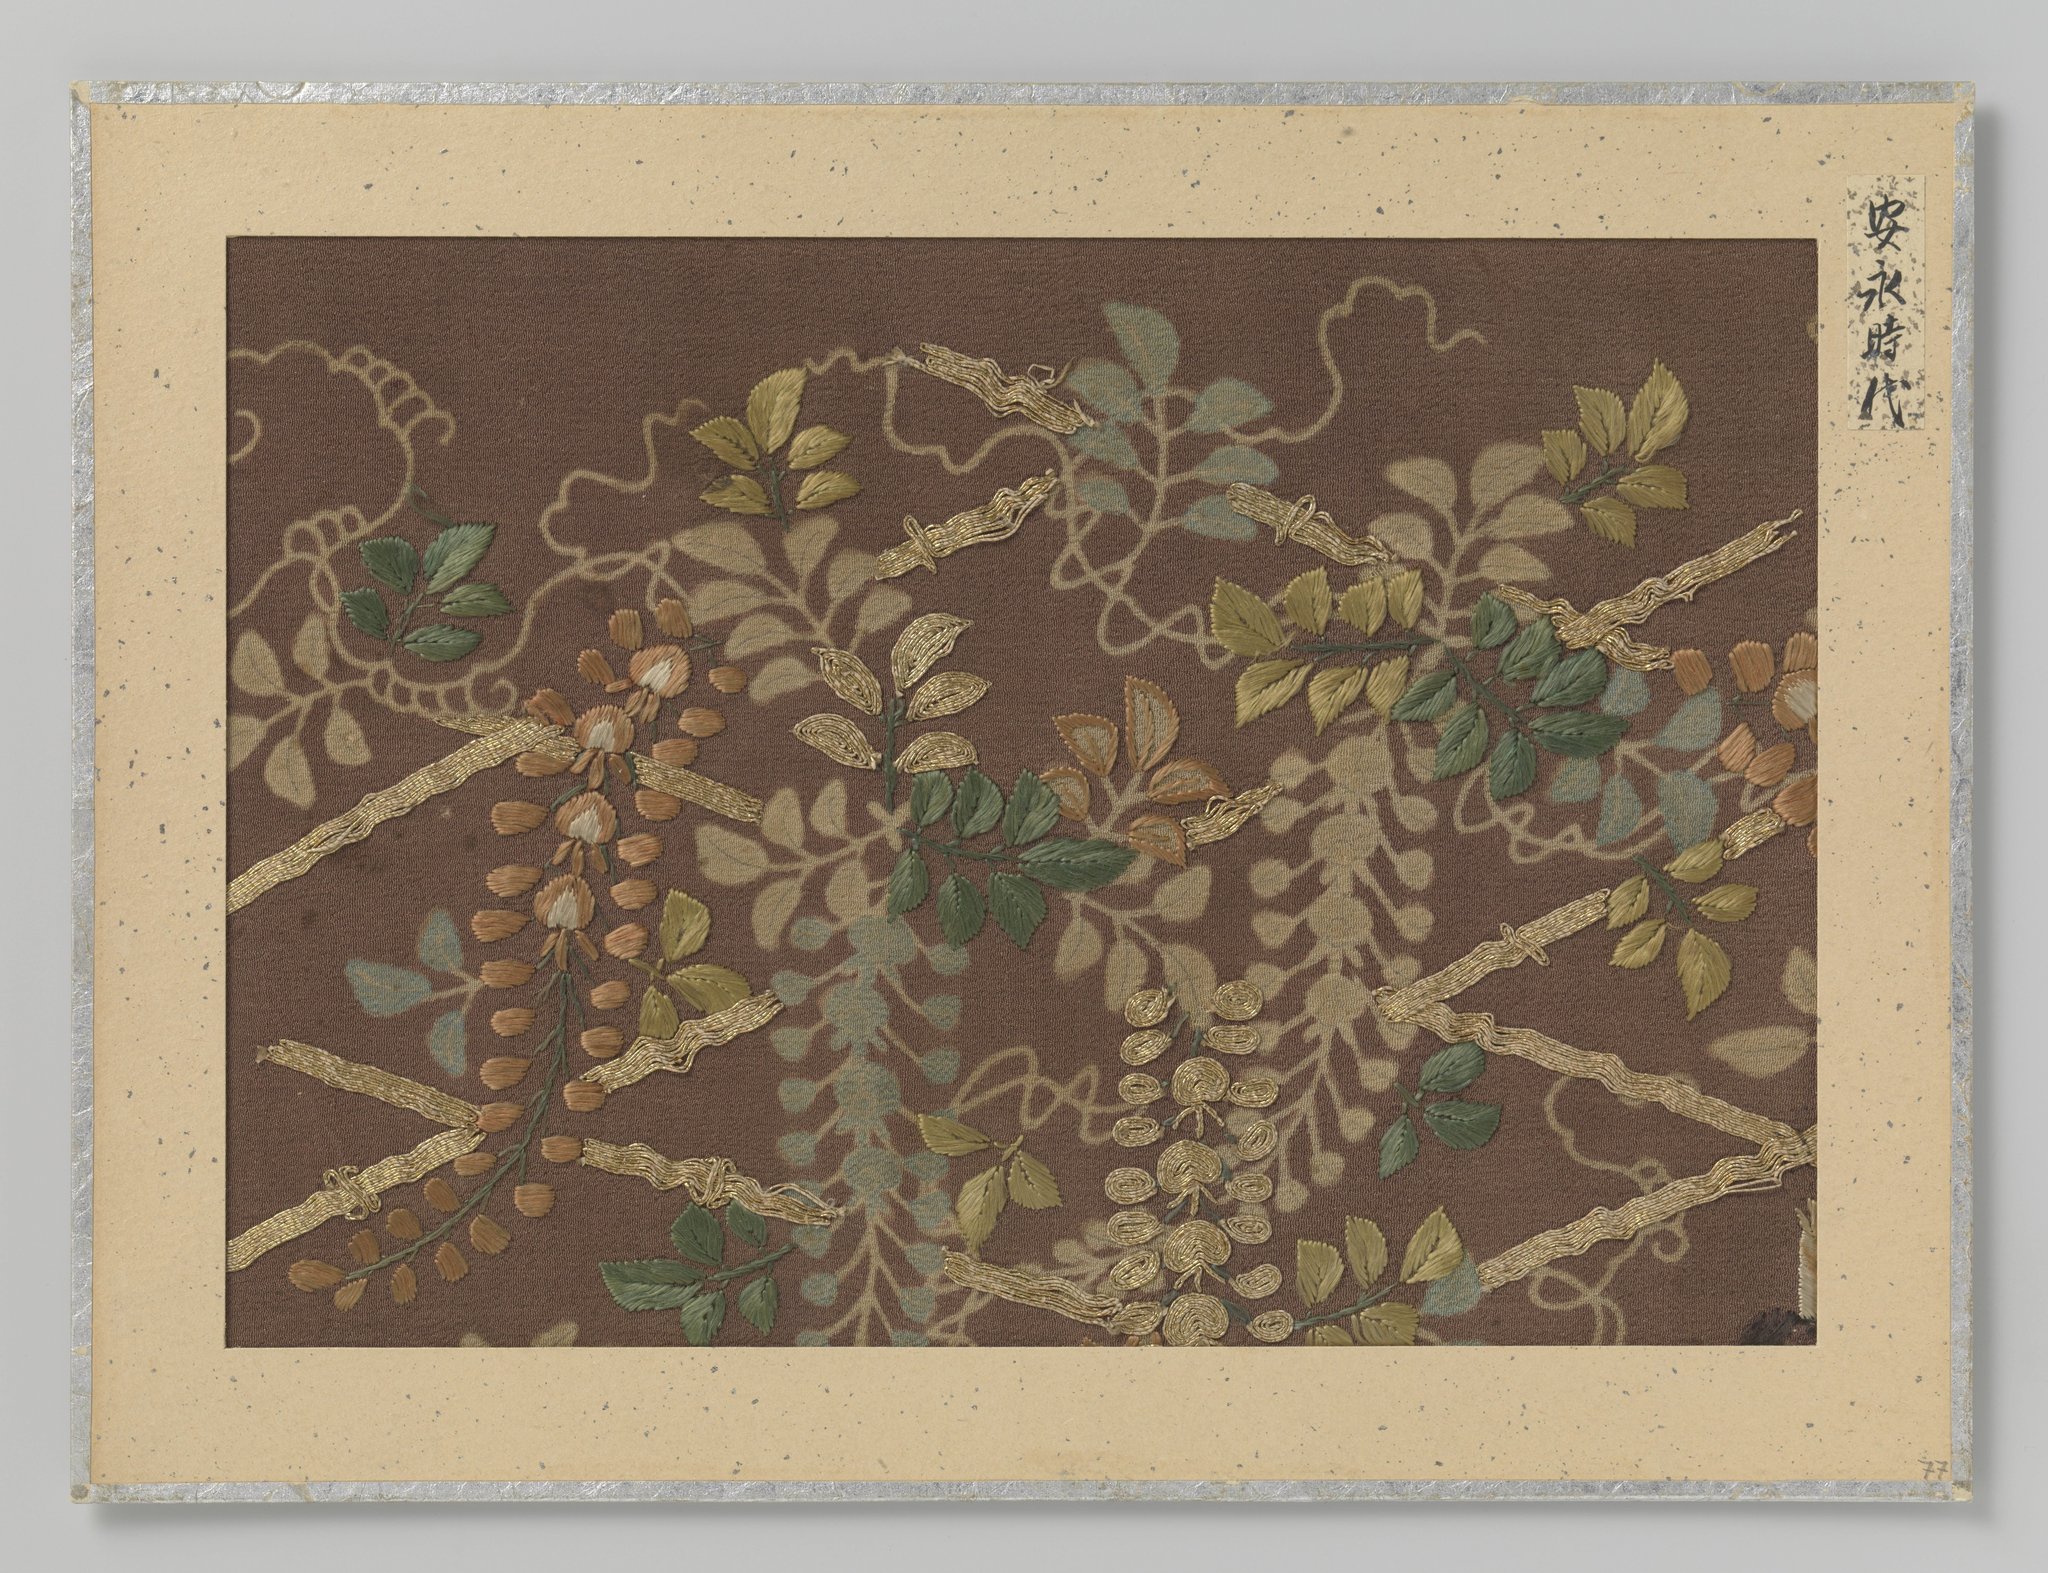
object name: textile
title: Textielfragment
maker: Anonymous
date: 1772-1780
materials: silk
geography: japan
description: Textielfragment, borduursel en druk van gouden regen op bruine achtergrond.